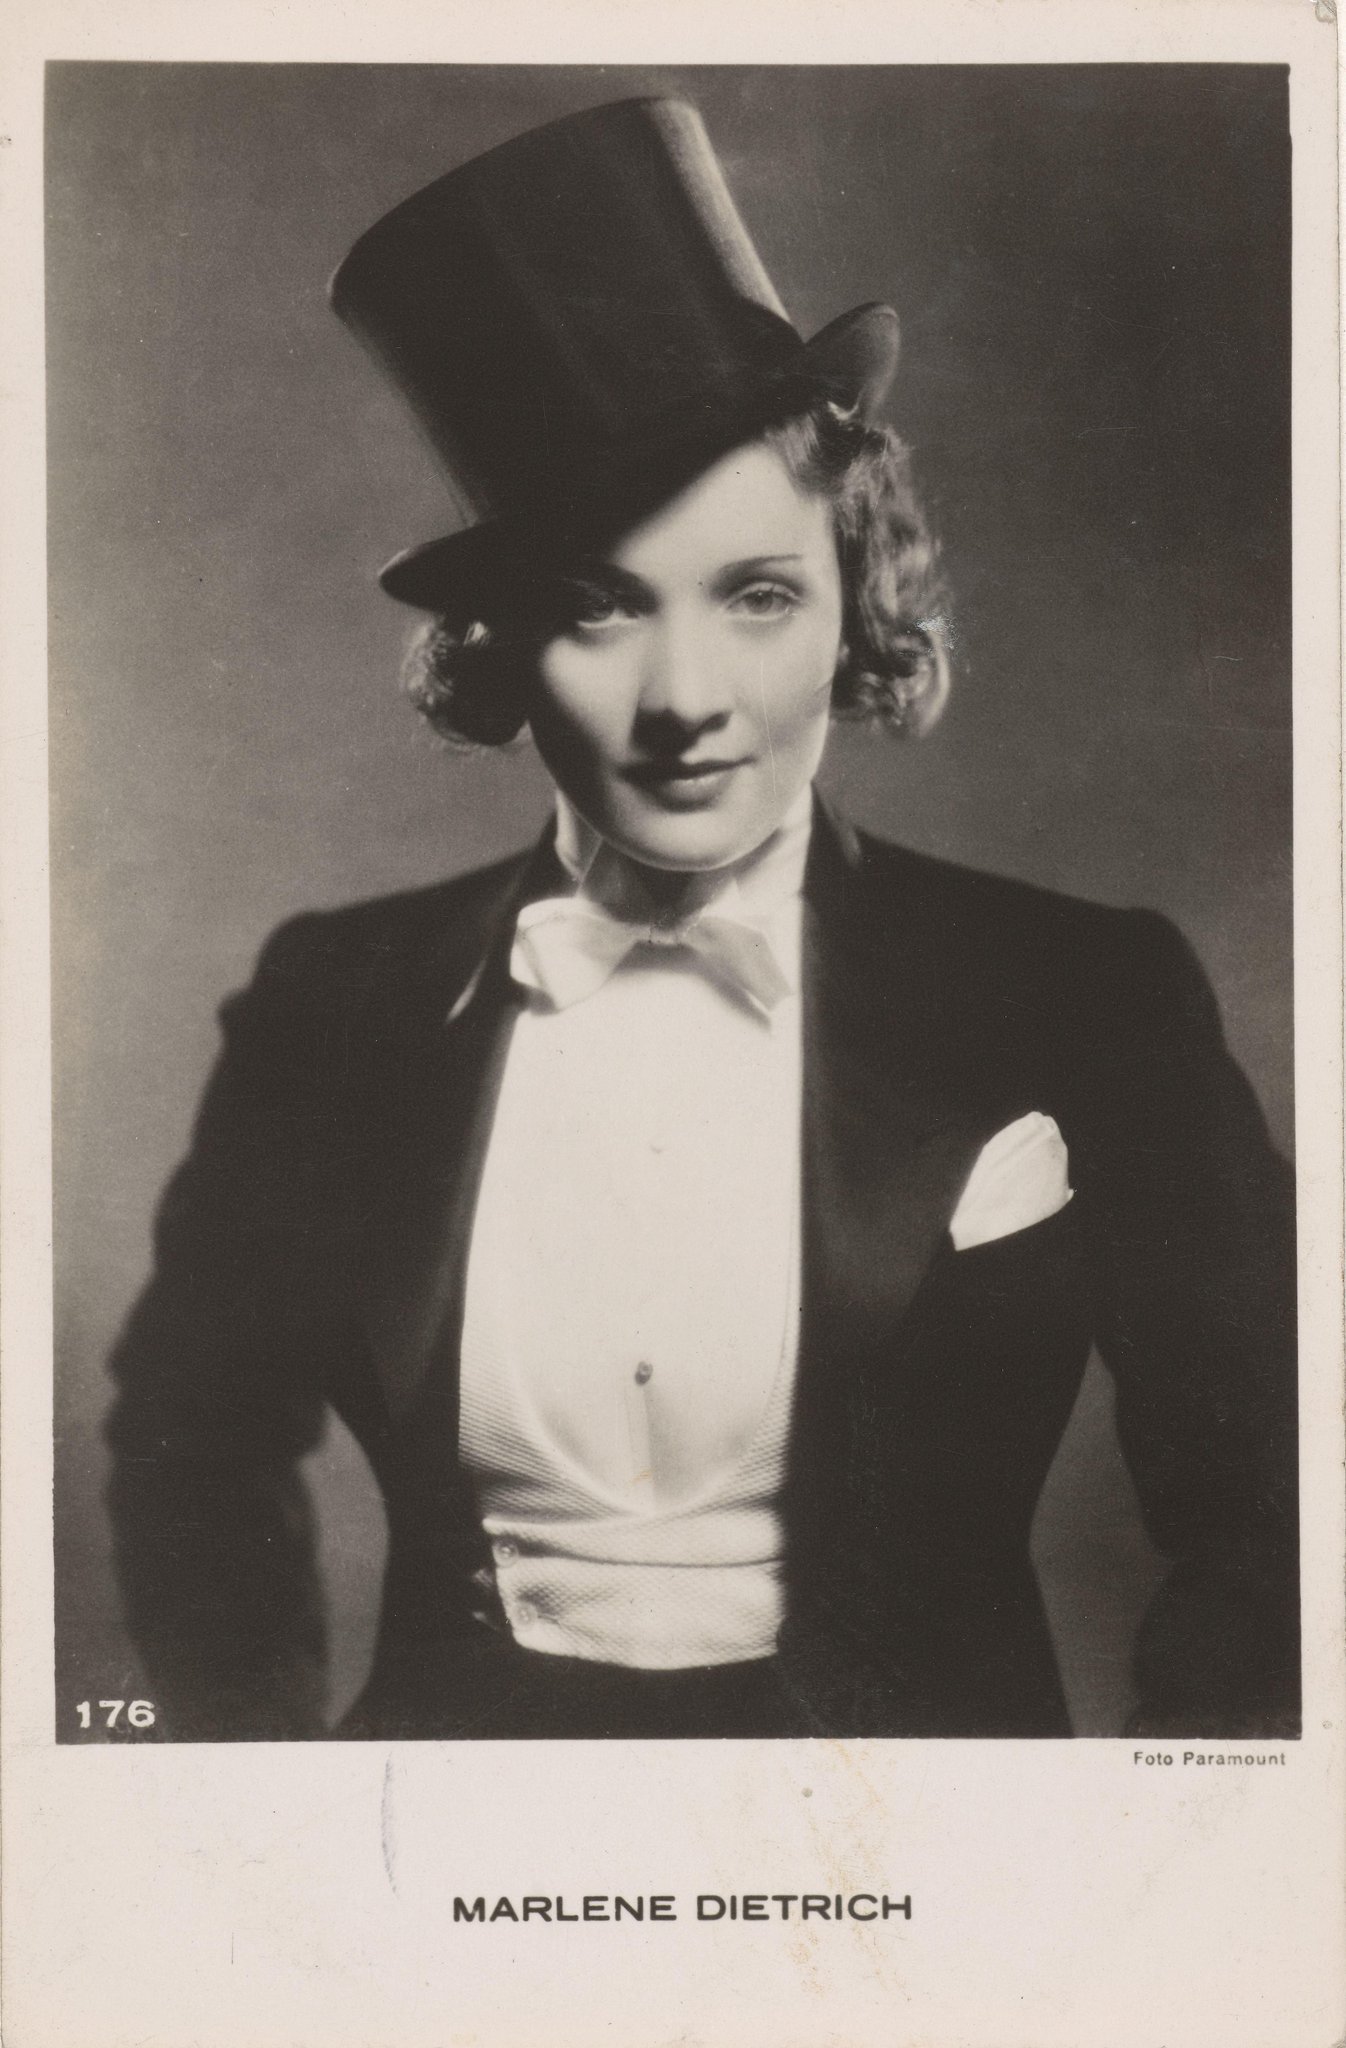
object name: ansichtkaart, prentbriefkaart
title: Marlene Dietrich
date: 1932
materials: photographic support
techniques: gelatin silver print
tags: berlin, paris